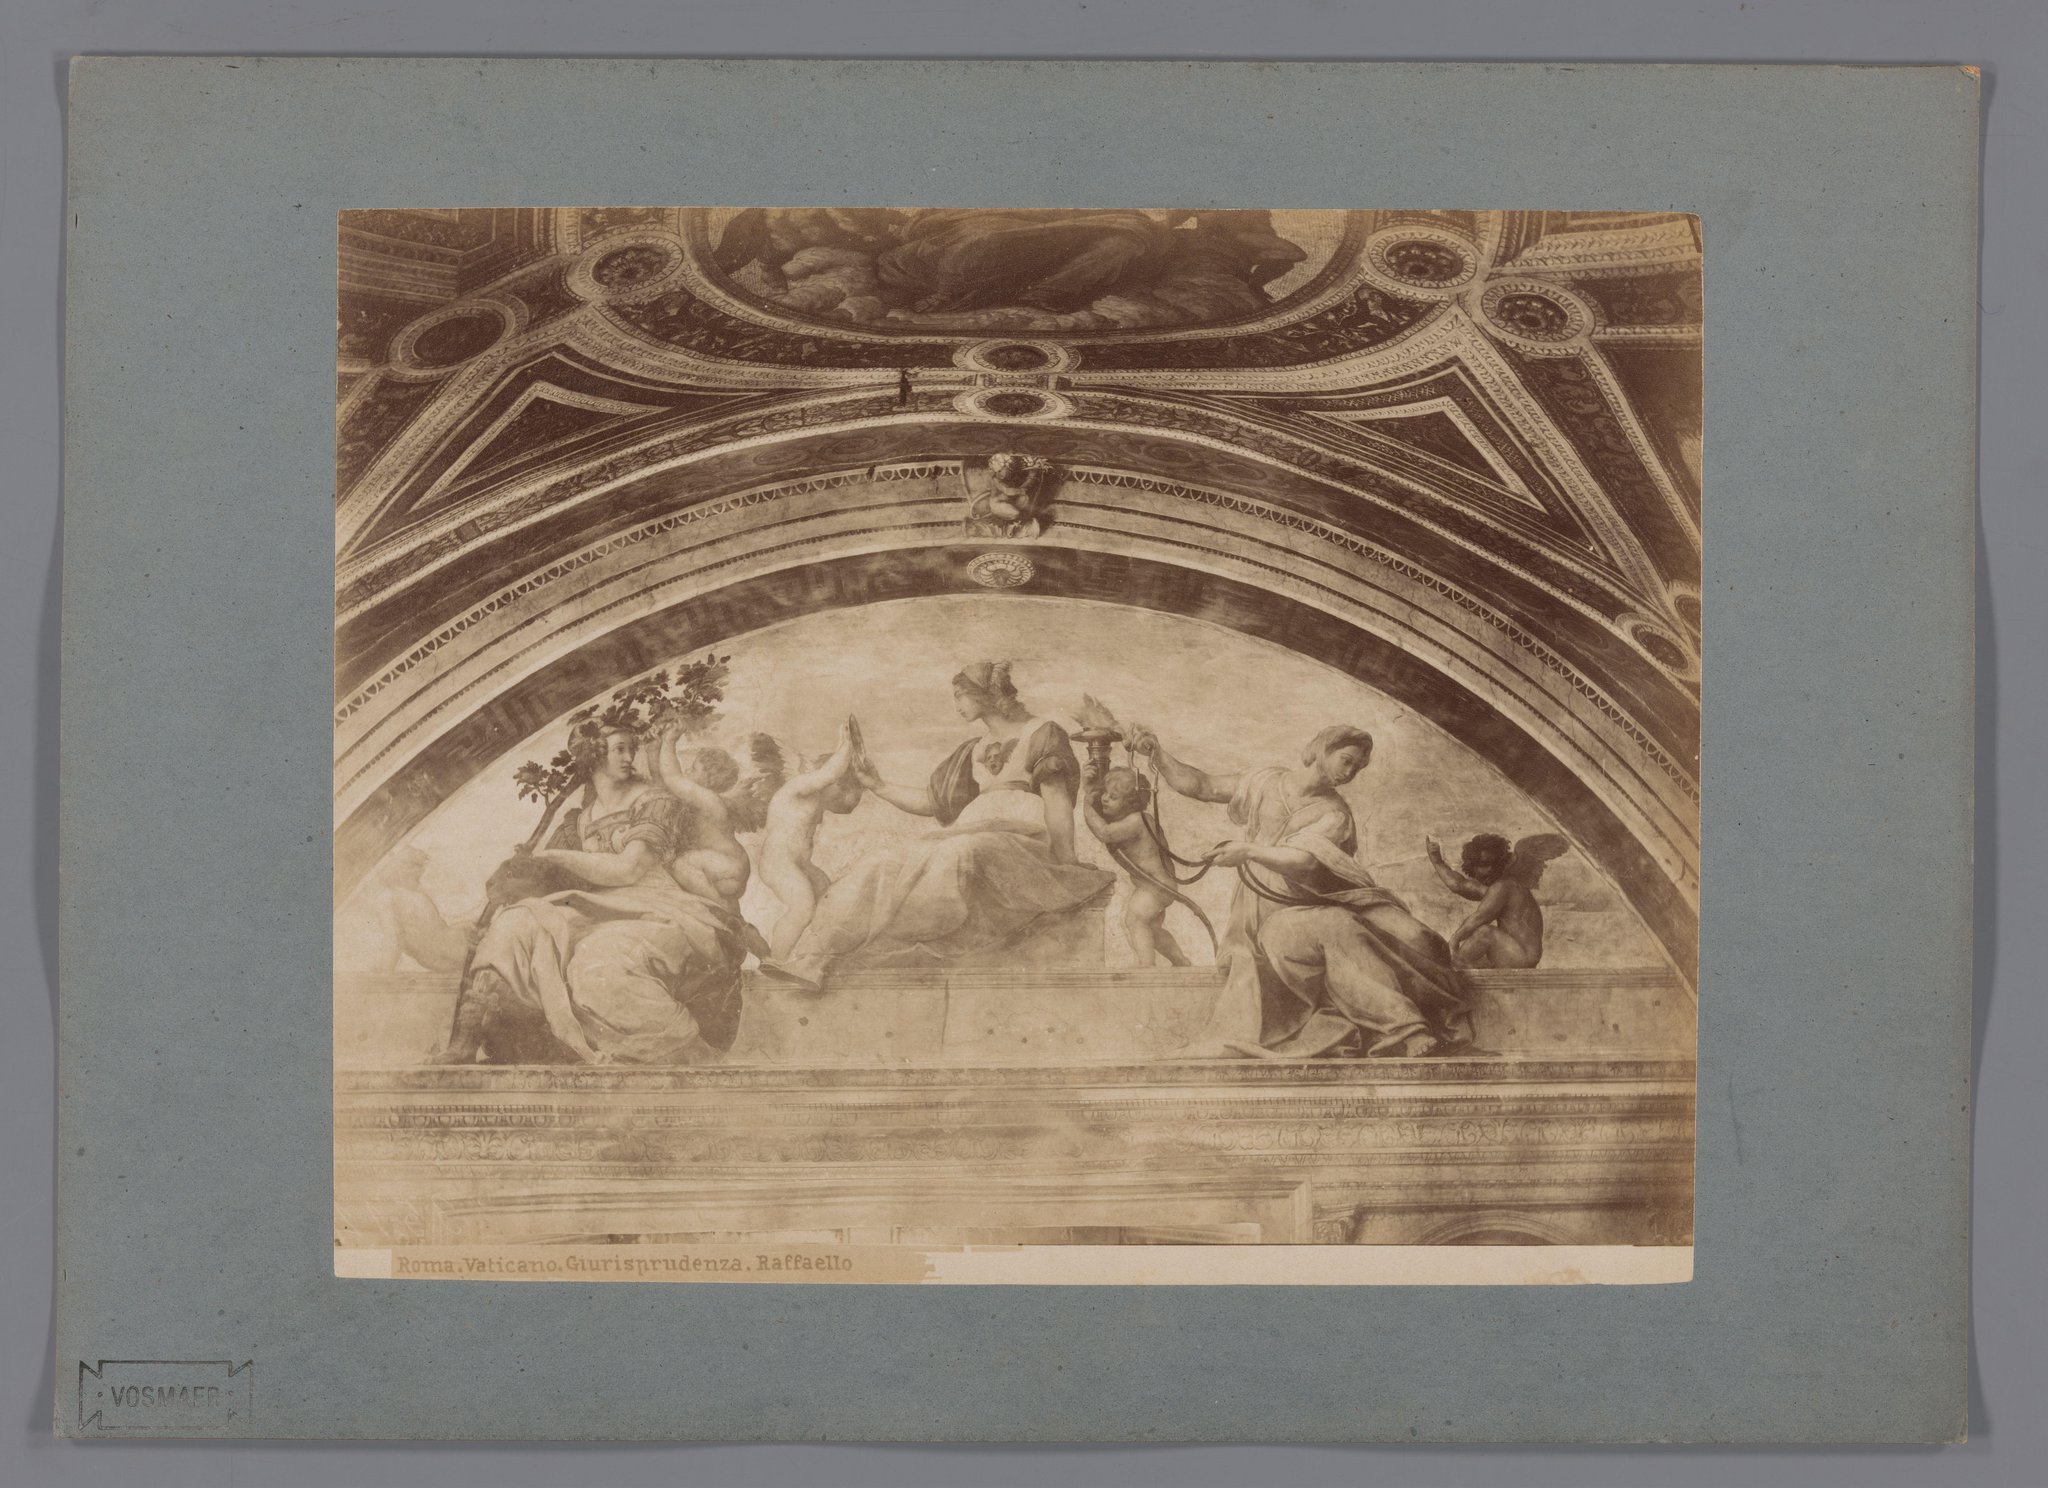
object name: reproduction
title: Roma. Vaticano. Giurisprudenza. Raffaello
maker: Anonymous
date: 1851-1900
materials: cardboard, paper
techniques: albumen print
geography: vatican city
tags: picture, painting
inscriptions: collector's mark: ‘VOSMAER’